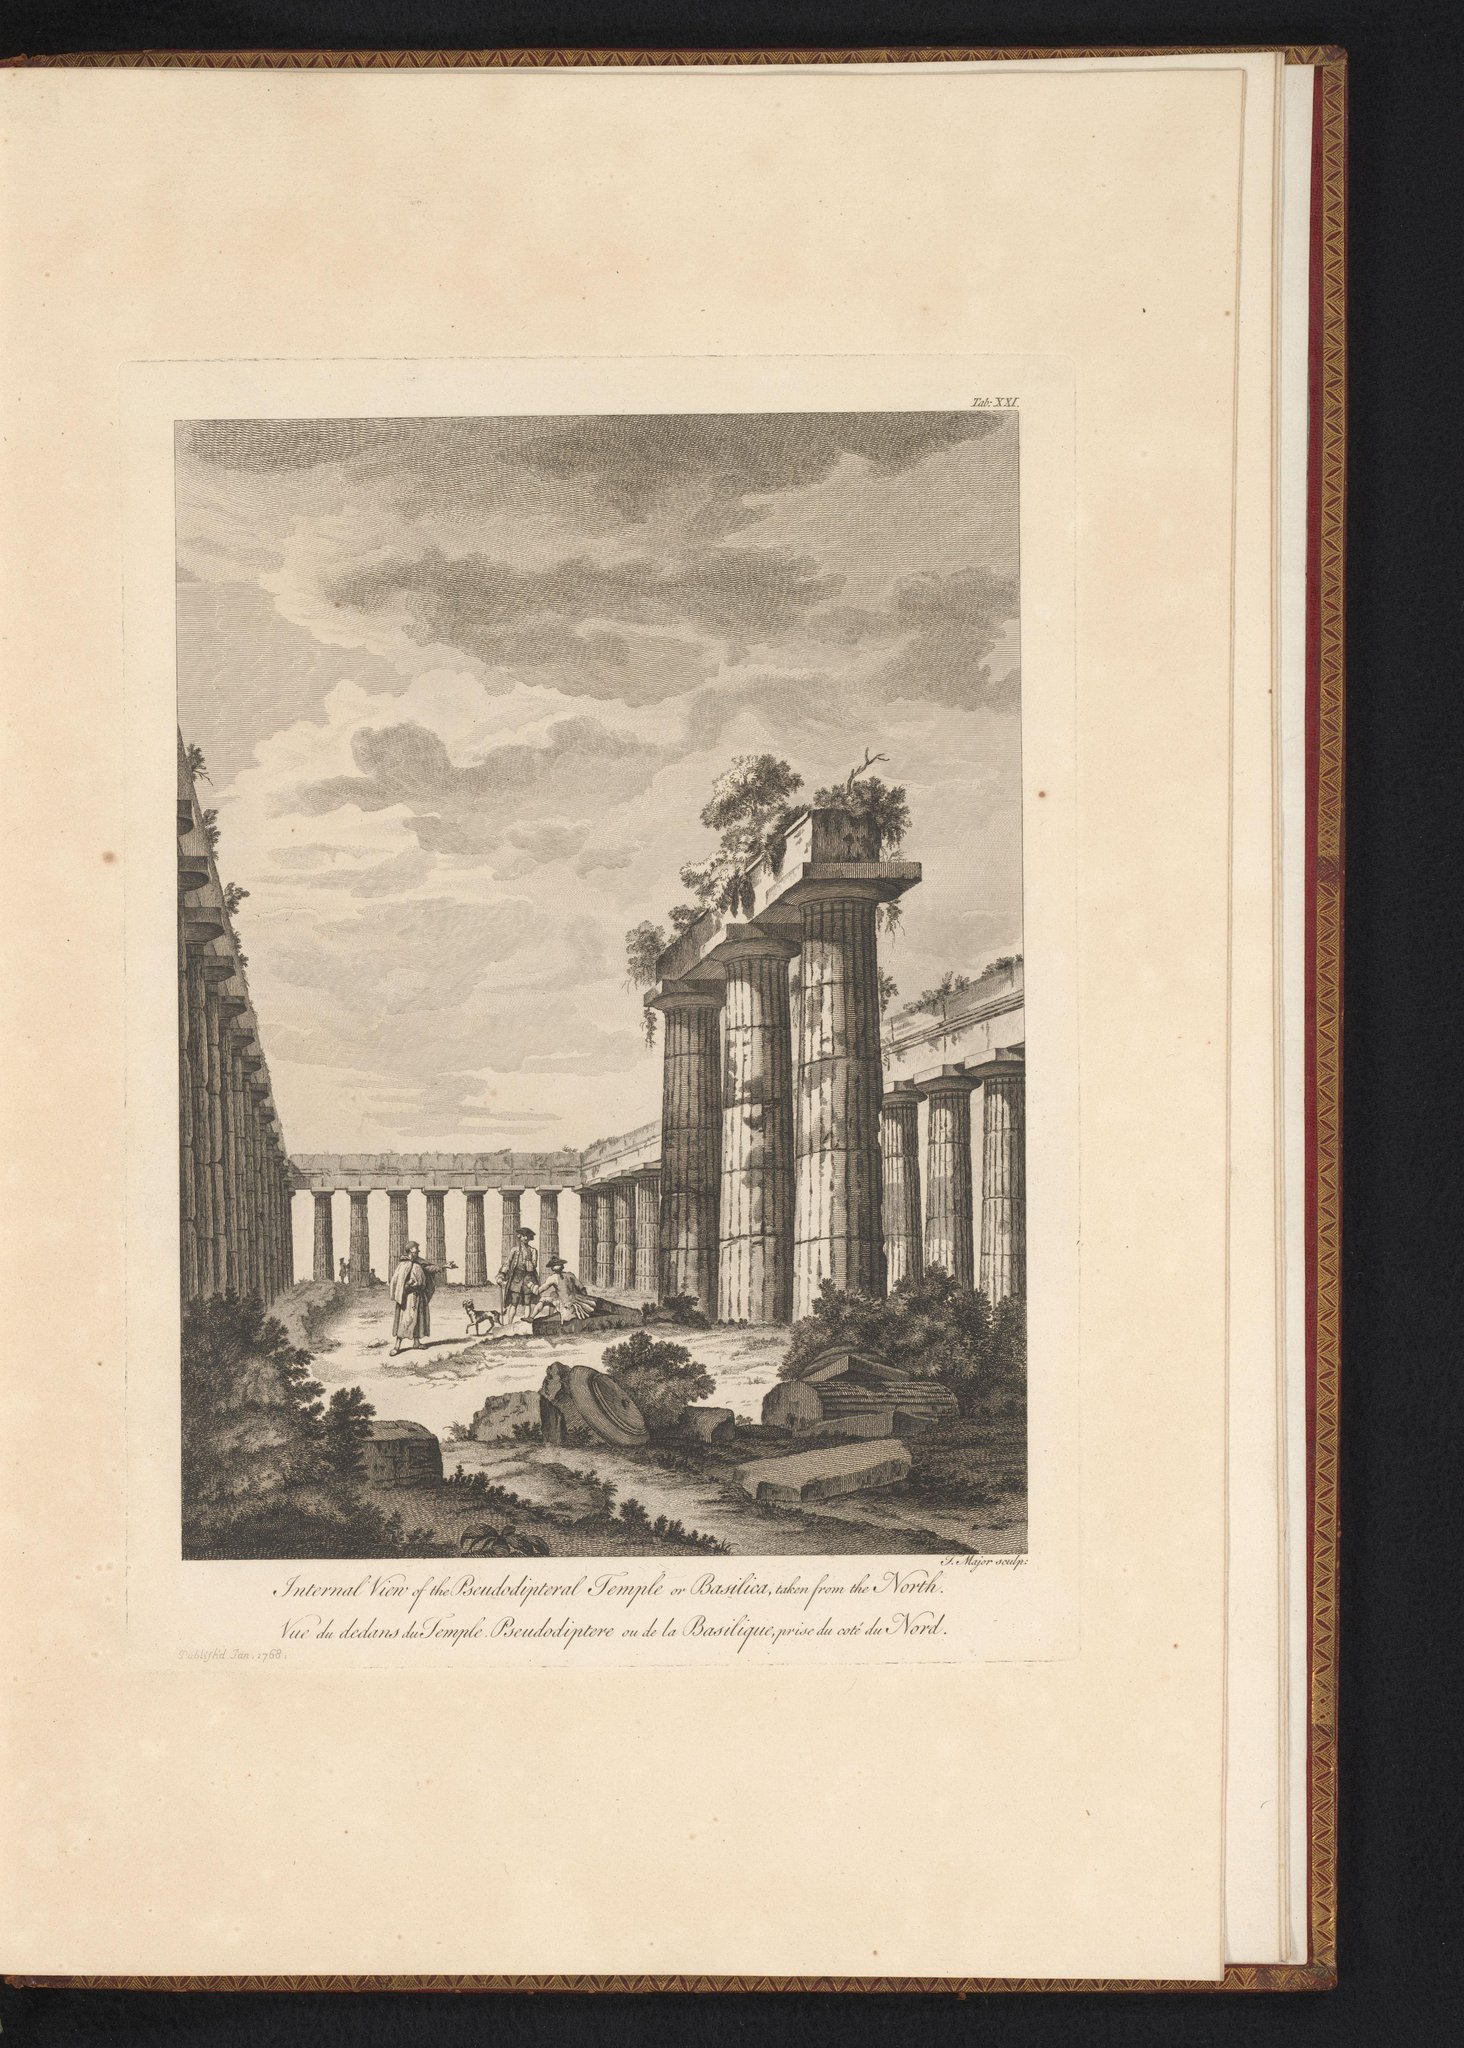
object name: page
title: Internal View of the Pseudodipteral Temple or Basilica, taken from the North / Vue du dedans du Temple Pseudodiptere ou de la Basilique, prise du coté du Nord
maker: thomas major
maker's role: print maker, publisher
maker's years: 1714-1799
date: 1768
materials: paper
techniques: engraving, etching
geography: london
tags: landscape with ruins (+ city(-scape) with figures, staffage), temple, shrine ~ greek religion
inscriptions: date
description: Deze prent is onderdeel van de reeks van 25 genummerde illustraties in deze uitgave.